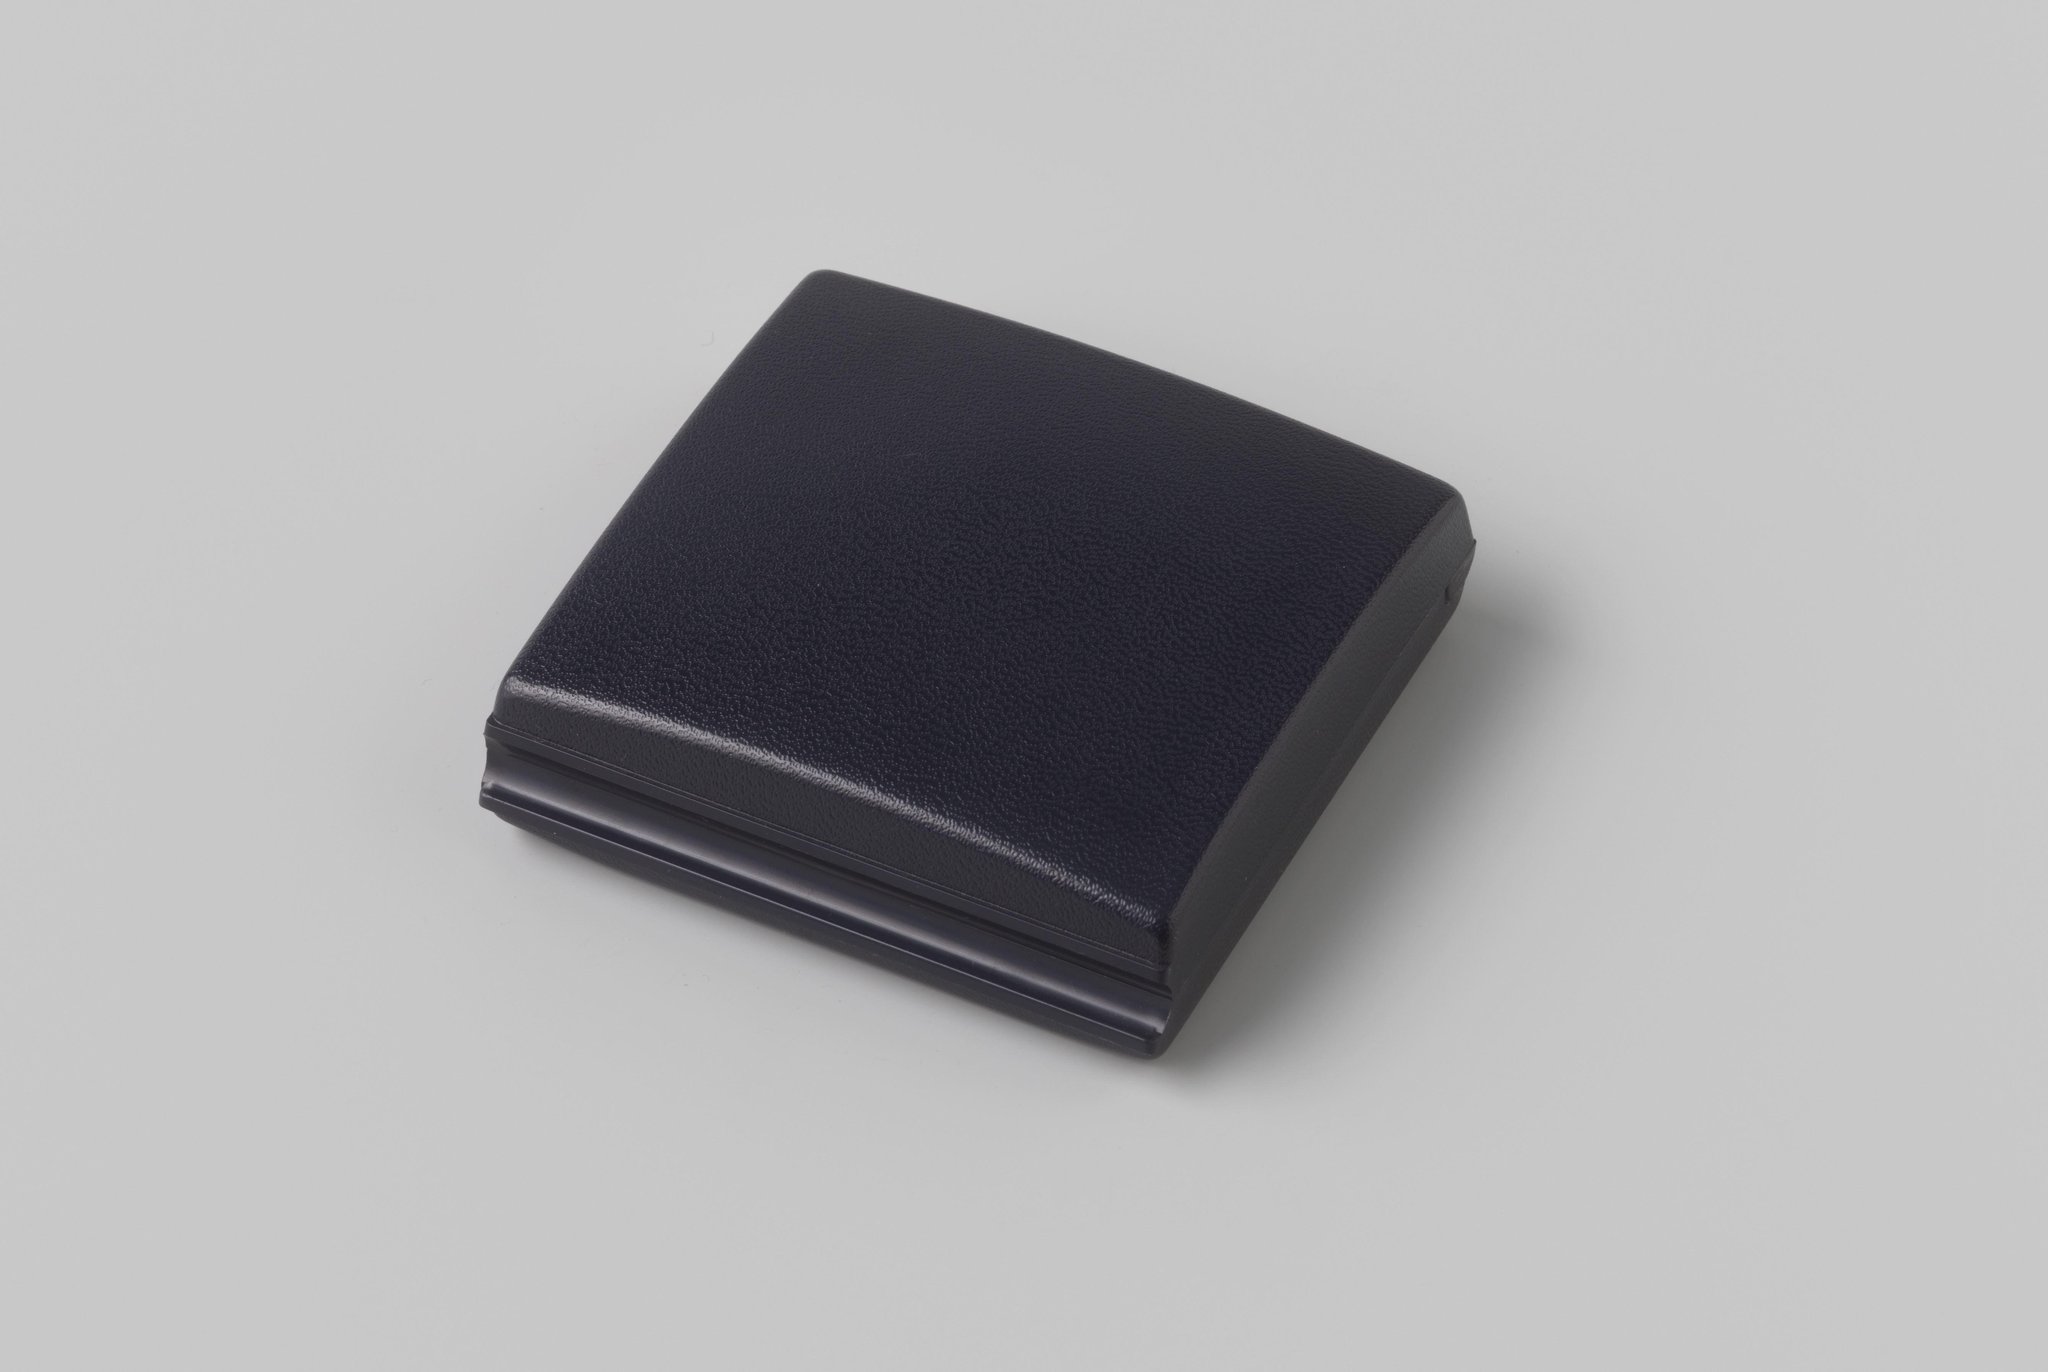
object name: box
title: Doosje bij penning A.W.L. Tjarda van Starkenborgh Stachouwer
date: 1986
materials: plastic, velvet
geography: zeist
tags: dutch east indies, the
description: Donkerblauw doosje. In deksel witte voering; onder blauw fluweel met uitsparing voor penning. Hierin penning en beschrijving met eerbetoon aan A.W.L. Tjarda van Starkenborgh Stachouwer als laatste gouverneur-generaal van Nederlands-Indië. Onderkant doosje een zilverkleurige sticker van fabrikant.